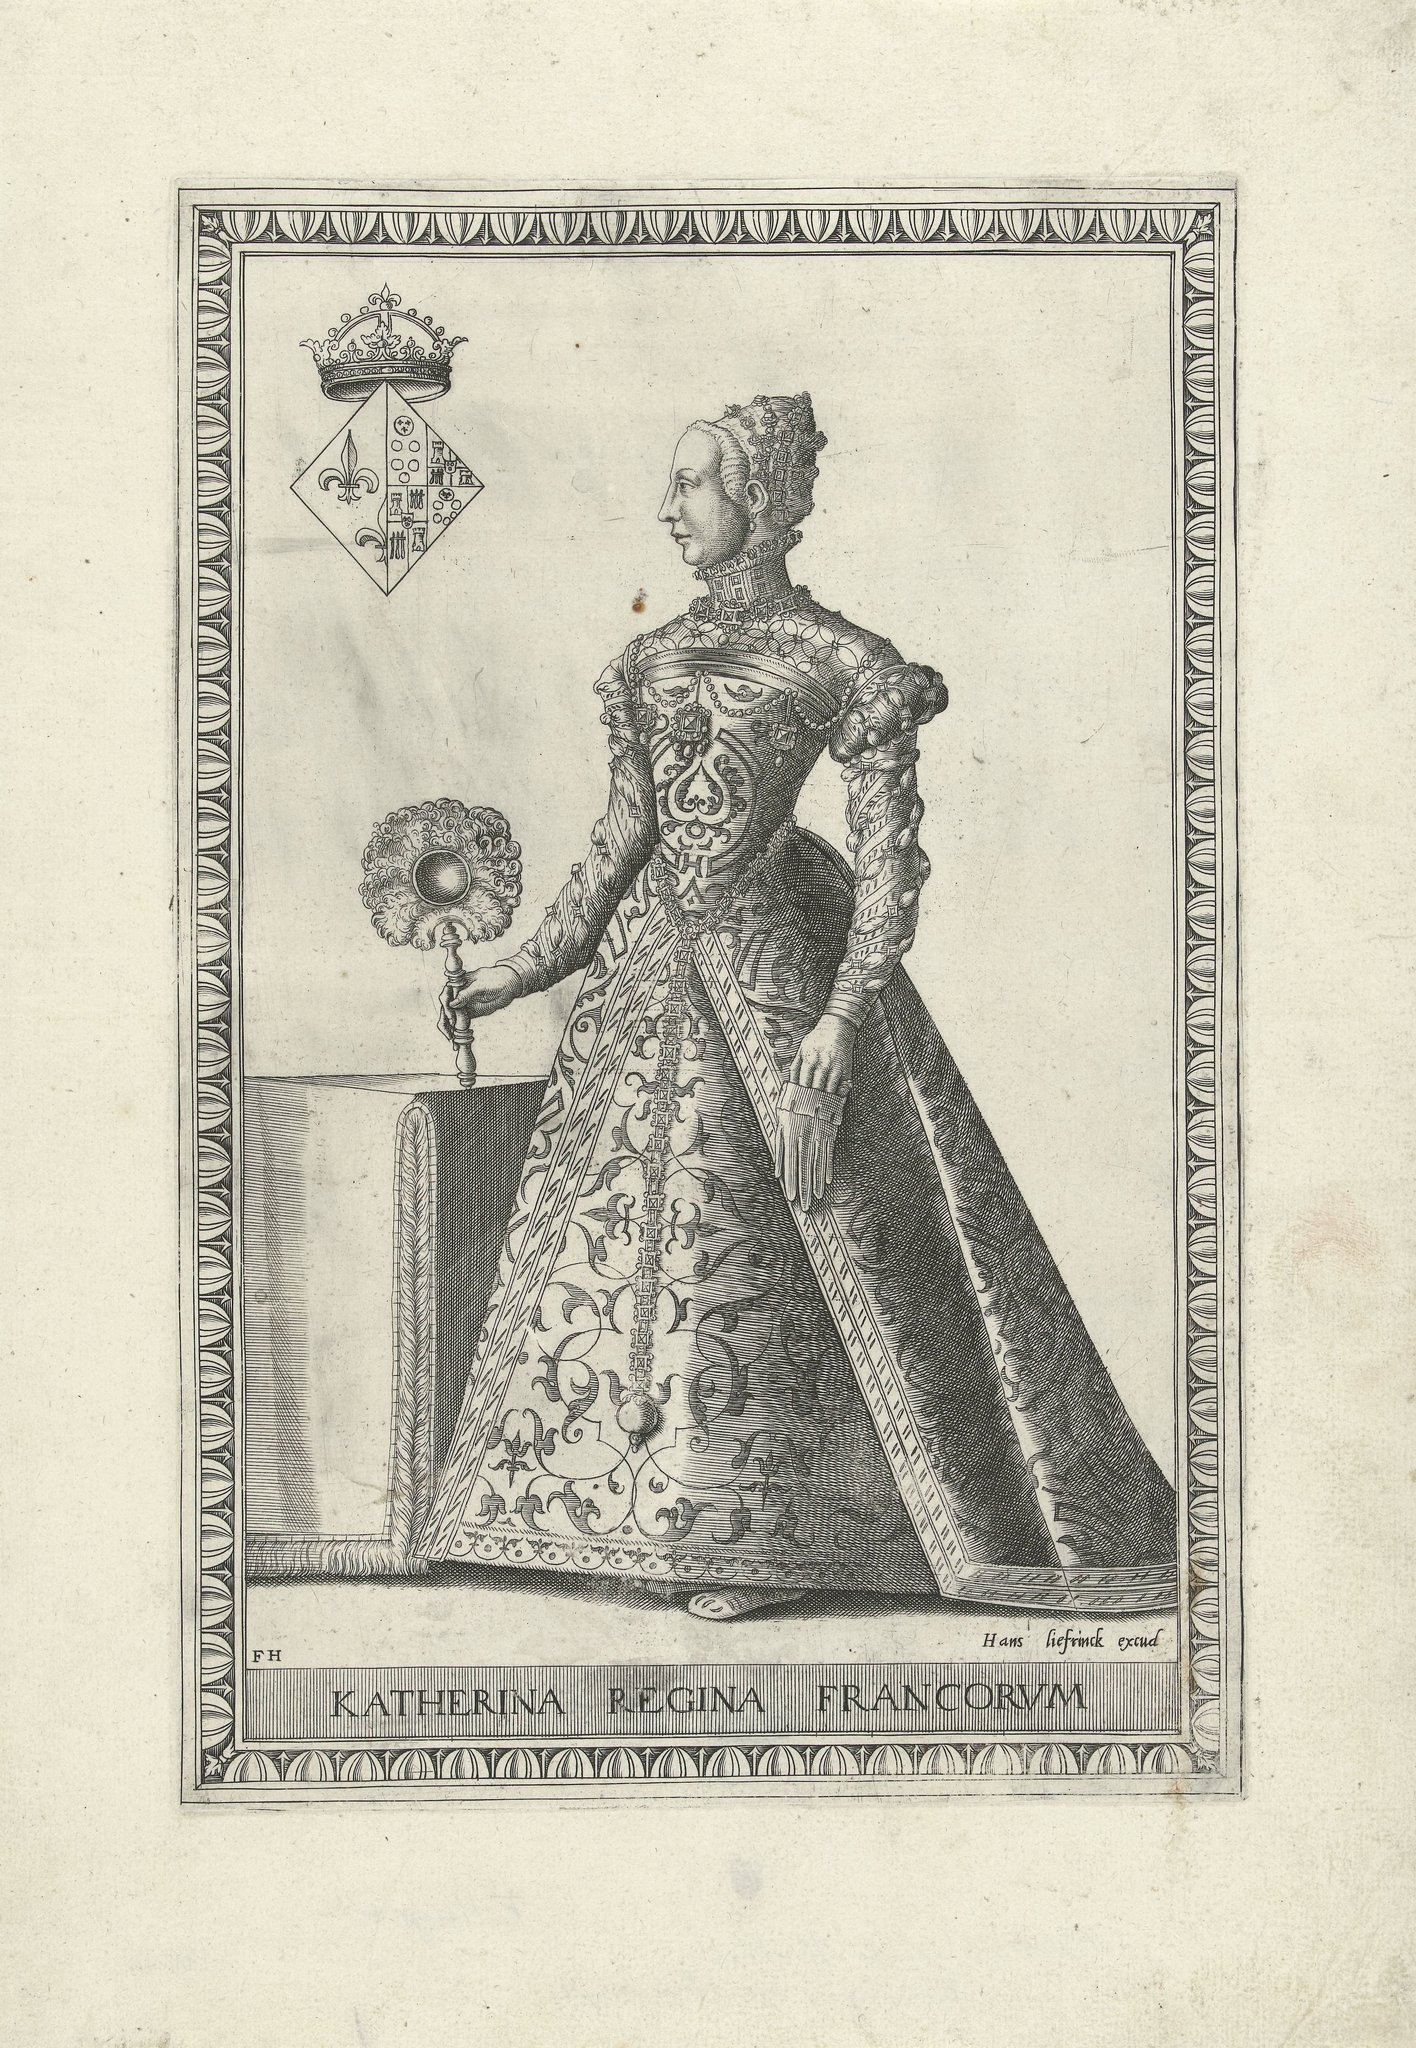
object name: print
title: Portret van Catharina de' Medici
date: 1546-1562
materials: paper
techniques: engraving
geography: antwerp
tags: catharina de'medici (koningin van frankrijk)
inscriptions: collector's mark: Lugt 2228, collector's mark: Lugt 151, collector's mark: Lugt 2760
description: Portret van Catharina de' Medici, koningin van Frankrijk, ten voeten uit naar links bij een tafel. In haar rechterhand een waaier en in haar linkerhand een handschoen. Linksboven haar wapenschild.